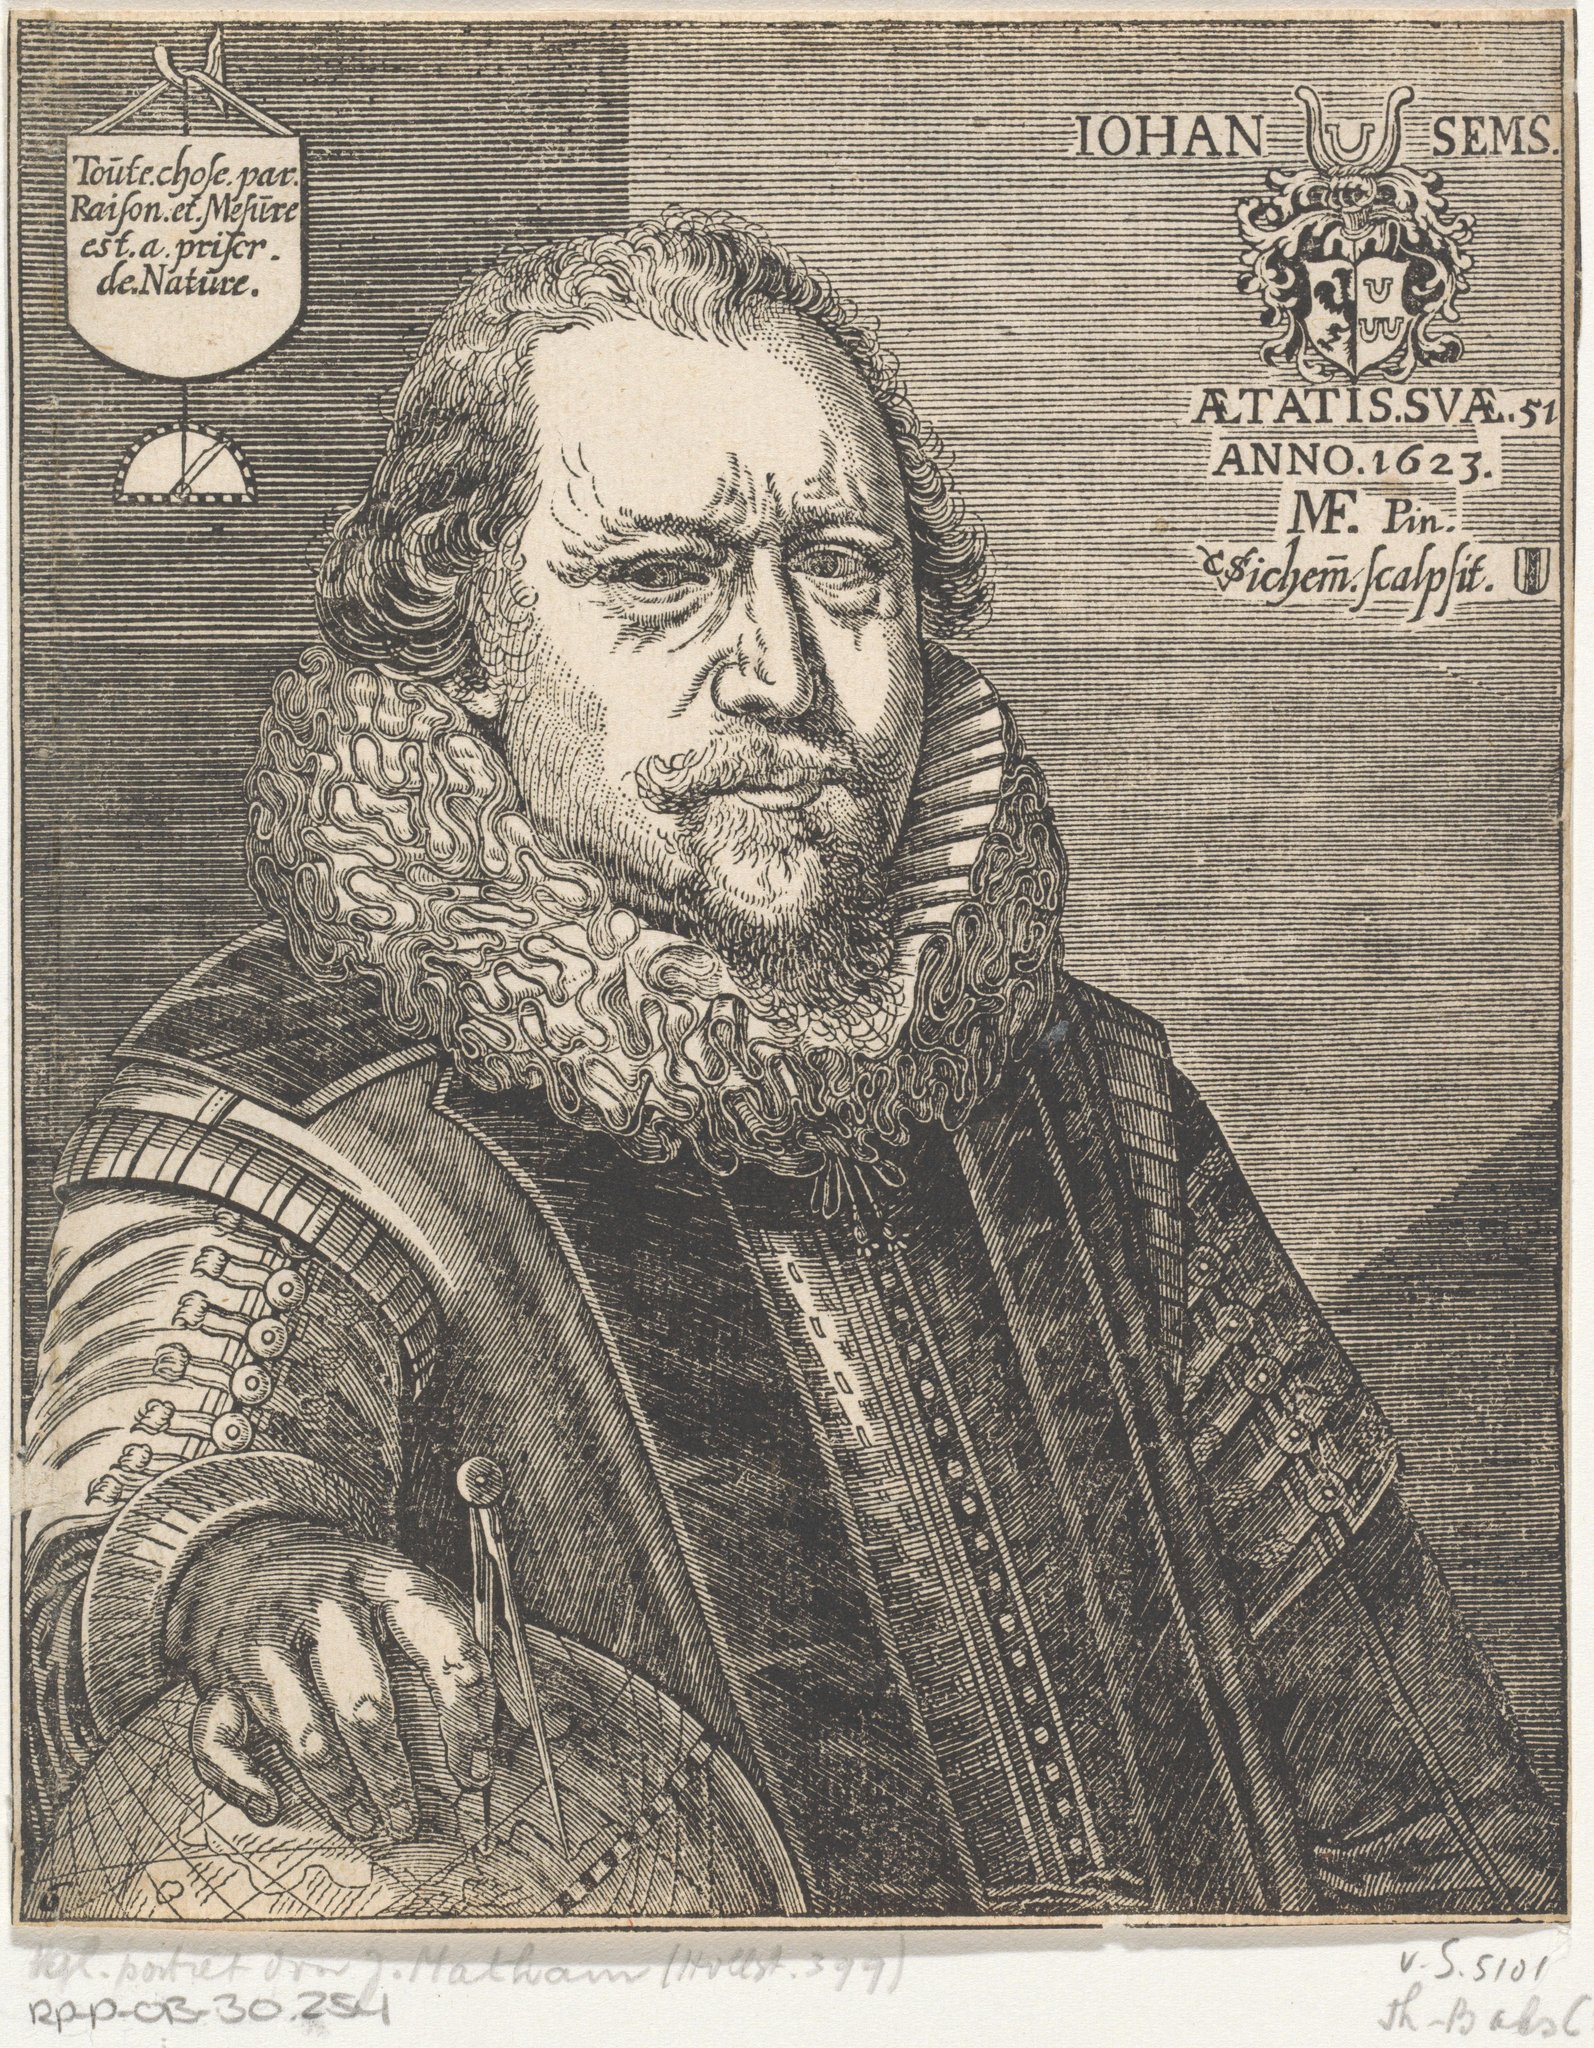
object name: print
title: Portret van Johan Sems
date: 1623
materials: paper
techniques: woodcut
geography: amsterdam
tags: johan sems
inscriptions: collector's mark: Lugt 2228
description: Portret van Johan Sems. Zijn rechterhand met daarin een passer ligt op een globe. Rechtsboven zijn wapen en zijn naam.